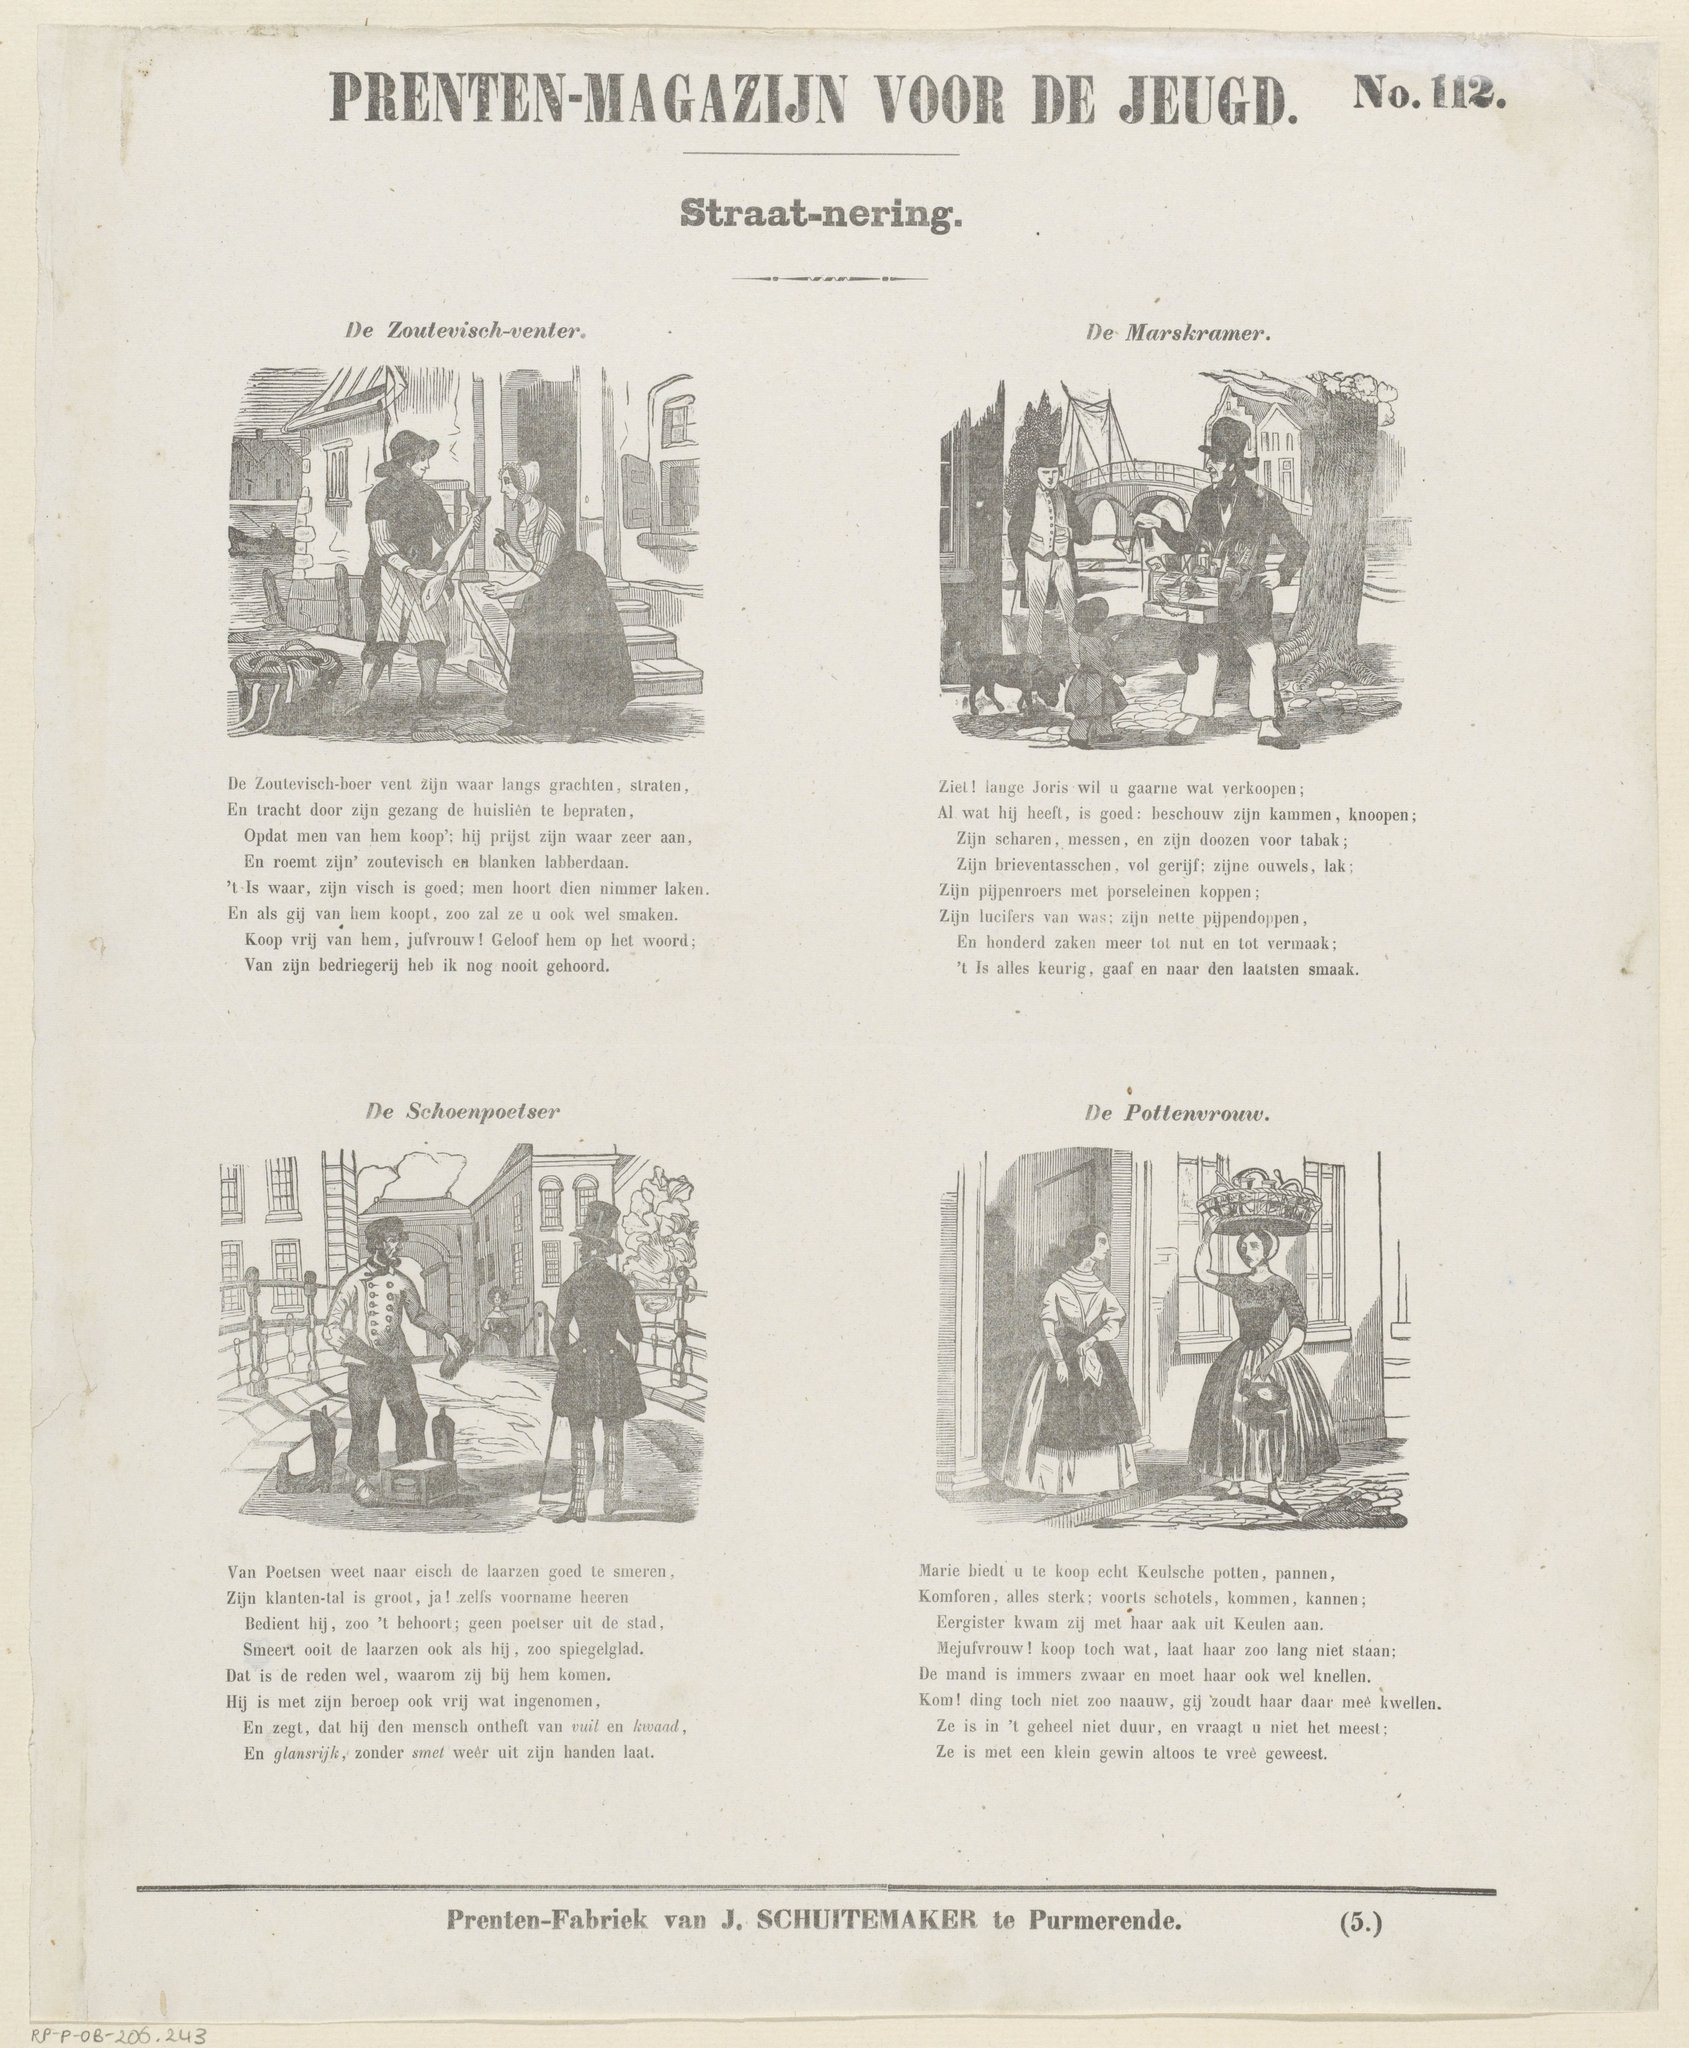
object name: popular print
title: Straat-nering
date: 1850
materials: paper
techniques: letterpress printing, engraving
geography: purmerend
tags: street-trader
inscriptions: collector's mark: Lugt 2760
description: Na voltooiing van de acht jaargangen van de reeks 'Prenten-magazijn voor de jeugd' in 1850 heeft Jan Schuitemaker al deze prenten heruitgegeven en omgenummerd als nr. 1 t/m 192. De oorspronkelijke jaargang wordt telkens nog vermeld rechtsonder op de prent. Binnen de jaargangen zijn prenten van hetzelfde thema in clusters van vier achter elkaar gezet.